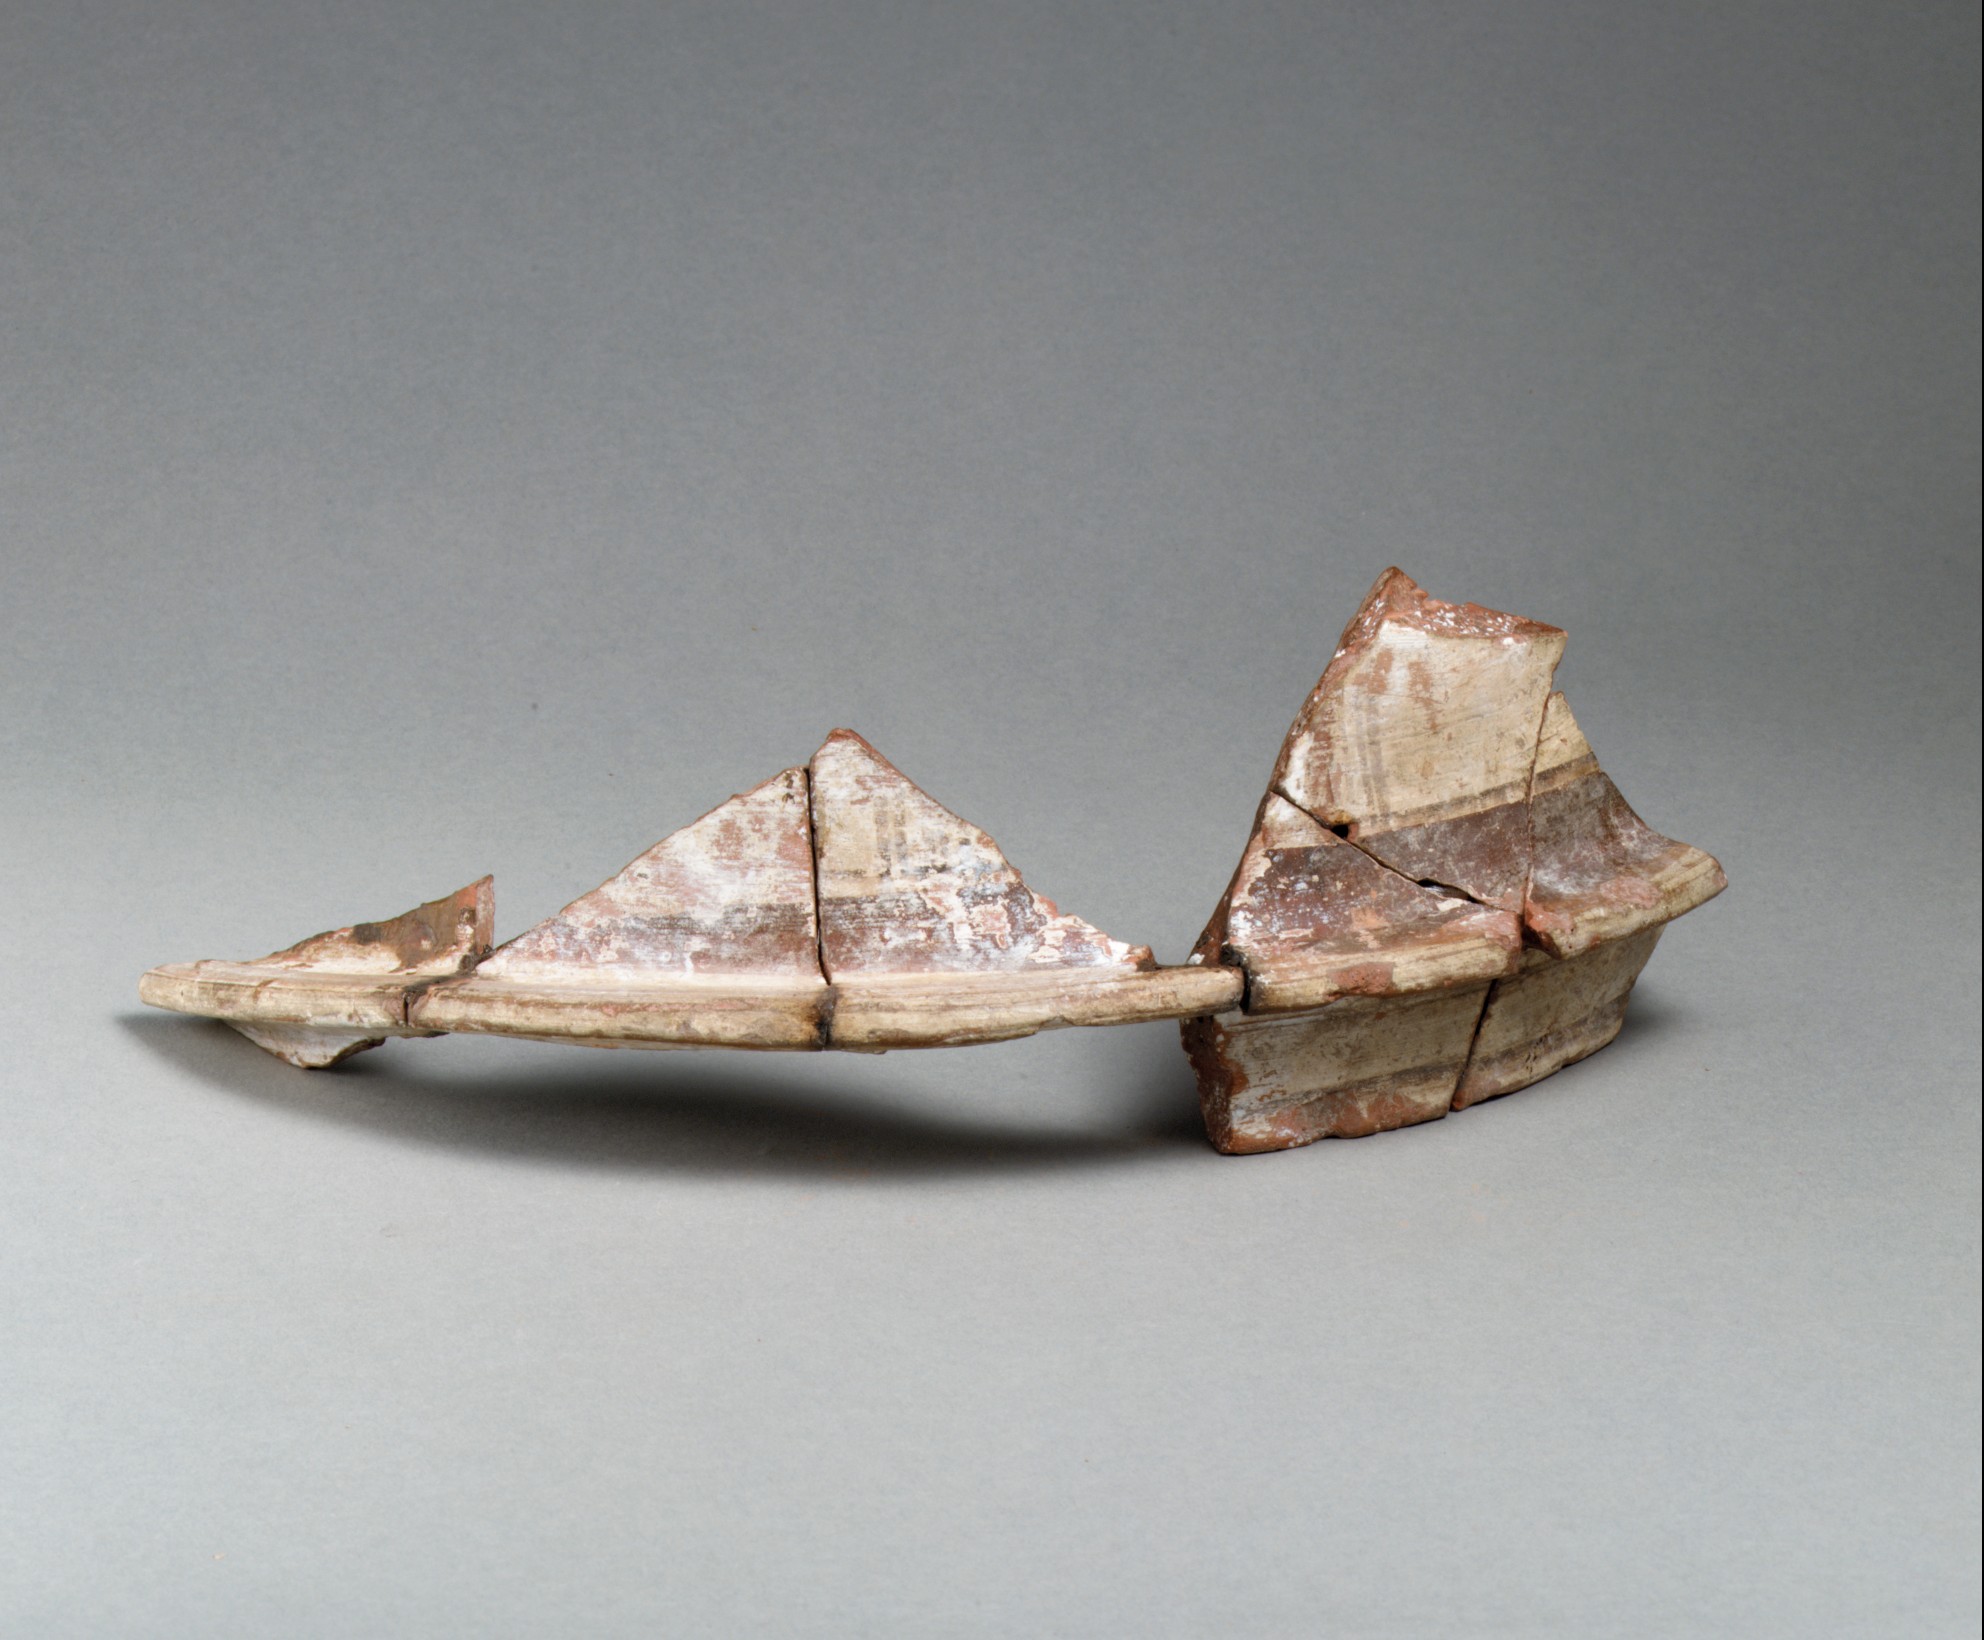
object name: vase fragment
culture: greek or lydian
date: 1050-700 BCE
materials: terracotta